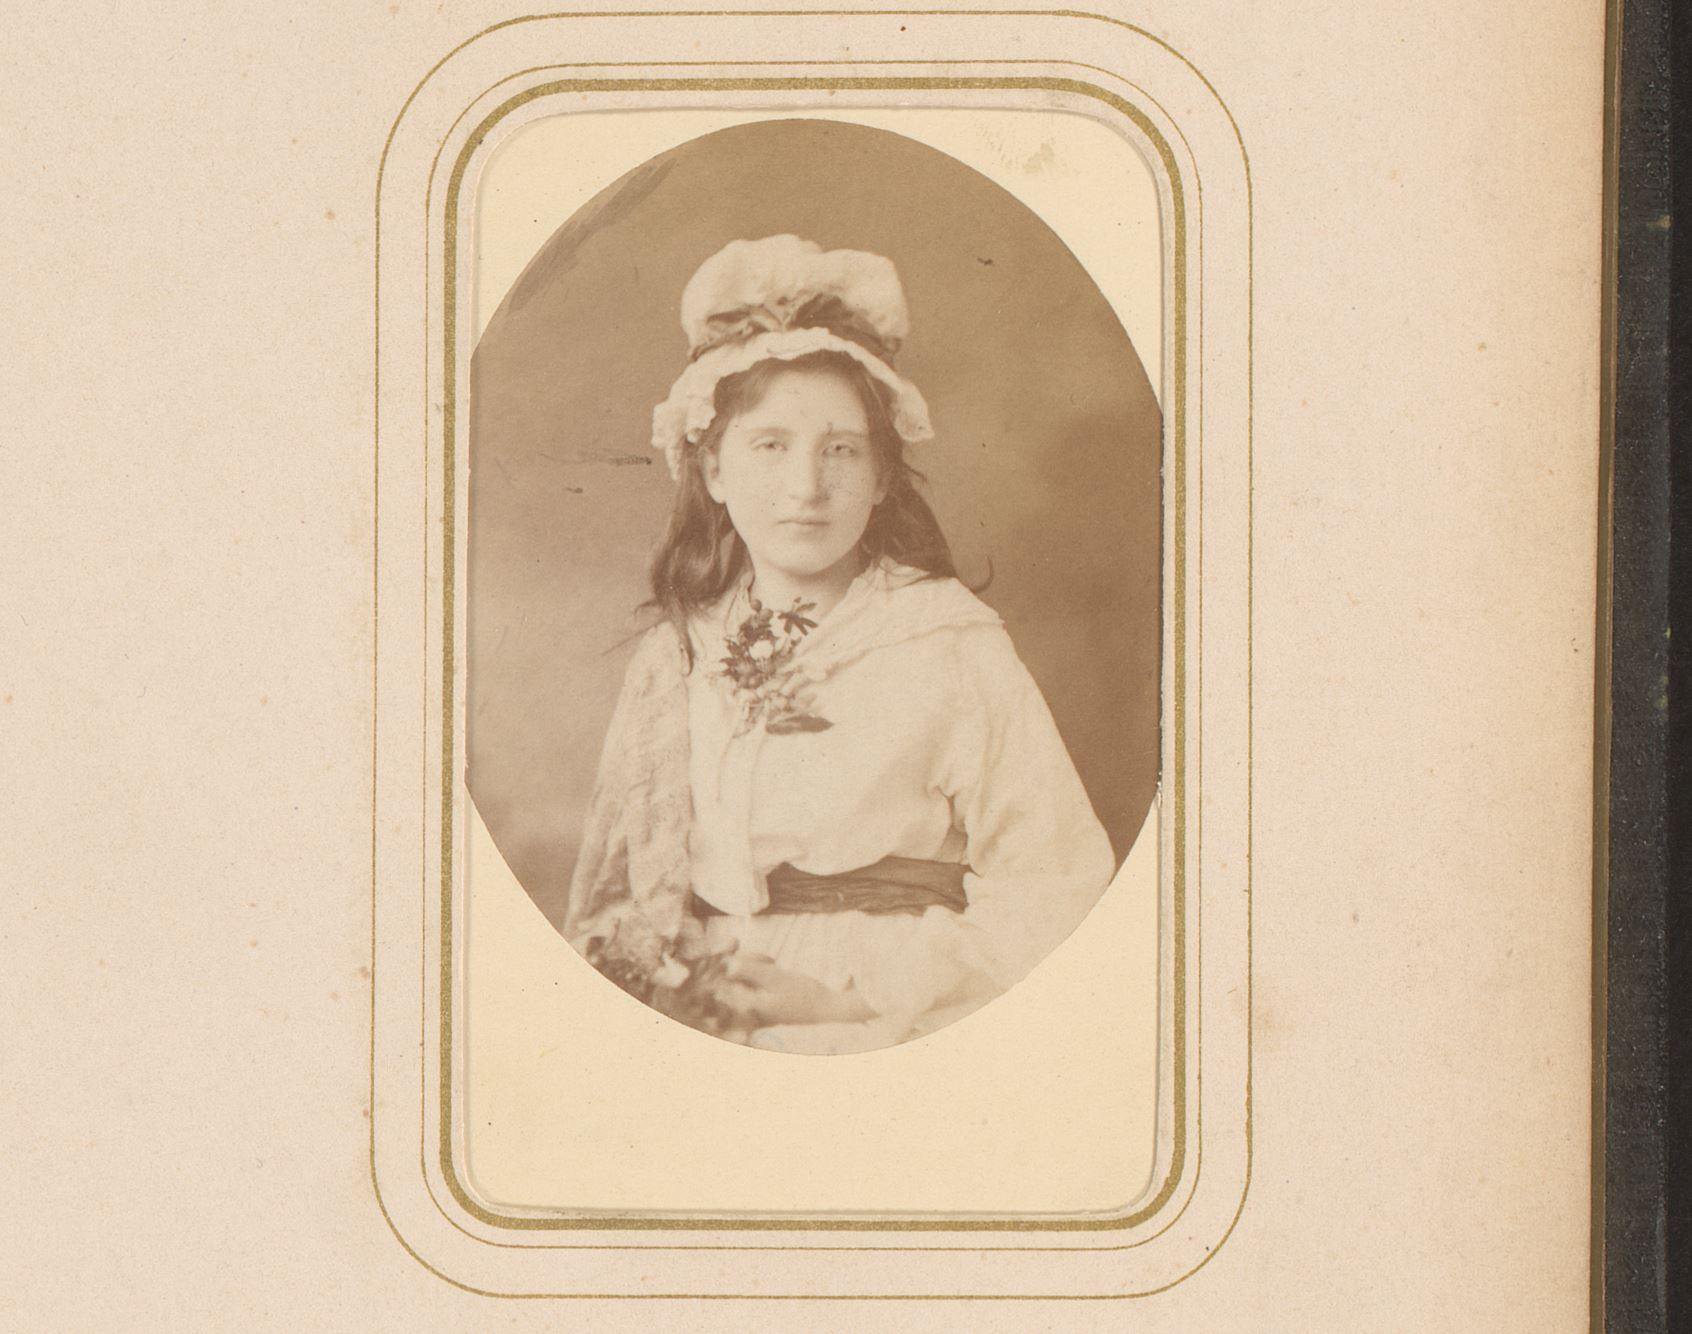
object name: album leaf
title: Portret van een meisje met hoed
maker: robert faulkner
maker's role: fotograaf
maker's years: 1823-1890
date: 1850-1890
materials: cardboard, photographic support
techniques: albumen print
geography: london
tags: historical persons - bb - woman, girl (child between toddler and youth), head-gear: cap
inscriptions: inscription: ‘ROBERT FAULKNER & Co./ ARTISTS & PHOTOGRAPHERS/ 21 Baker St/ Portman Square/ LONDON/ From 46 Kensington Gardens Square/ BAYSWATER/ No. of Negative/ 21940/ From this negative which will be/ carefully preserved enlargements/ finished in oil, water colors, crayons,/ or in imperishable & beautiful enamel/ can be made at any time.’